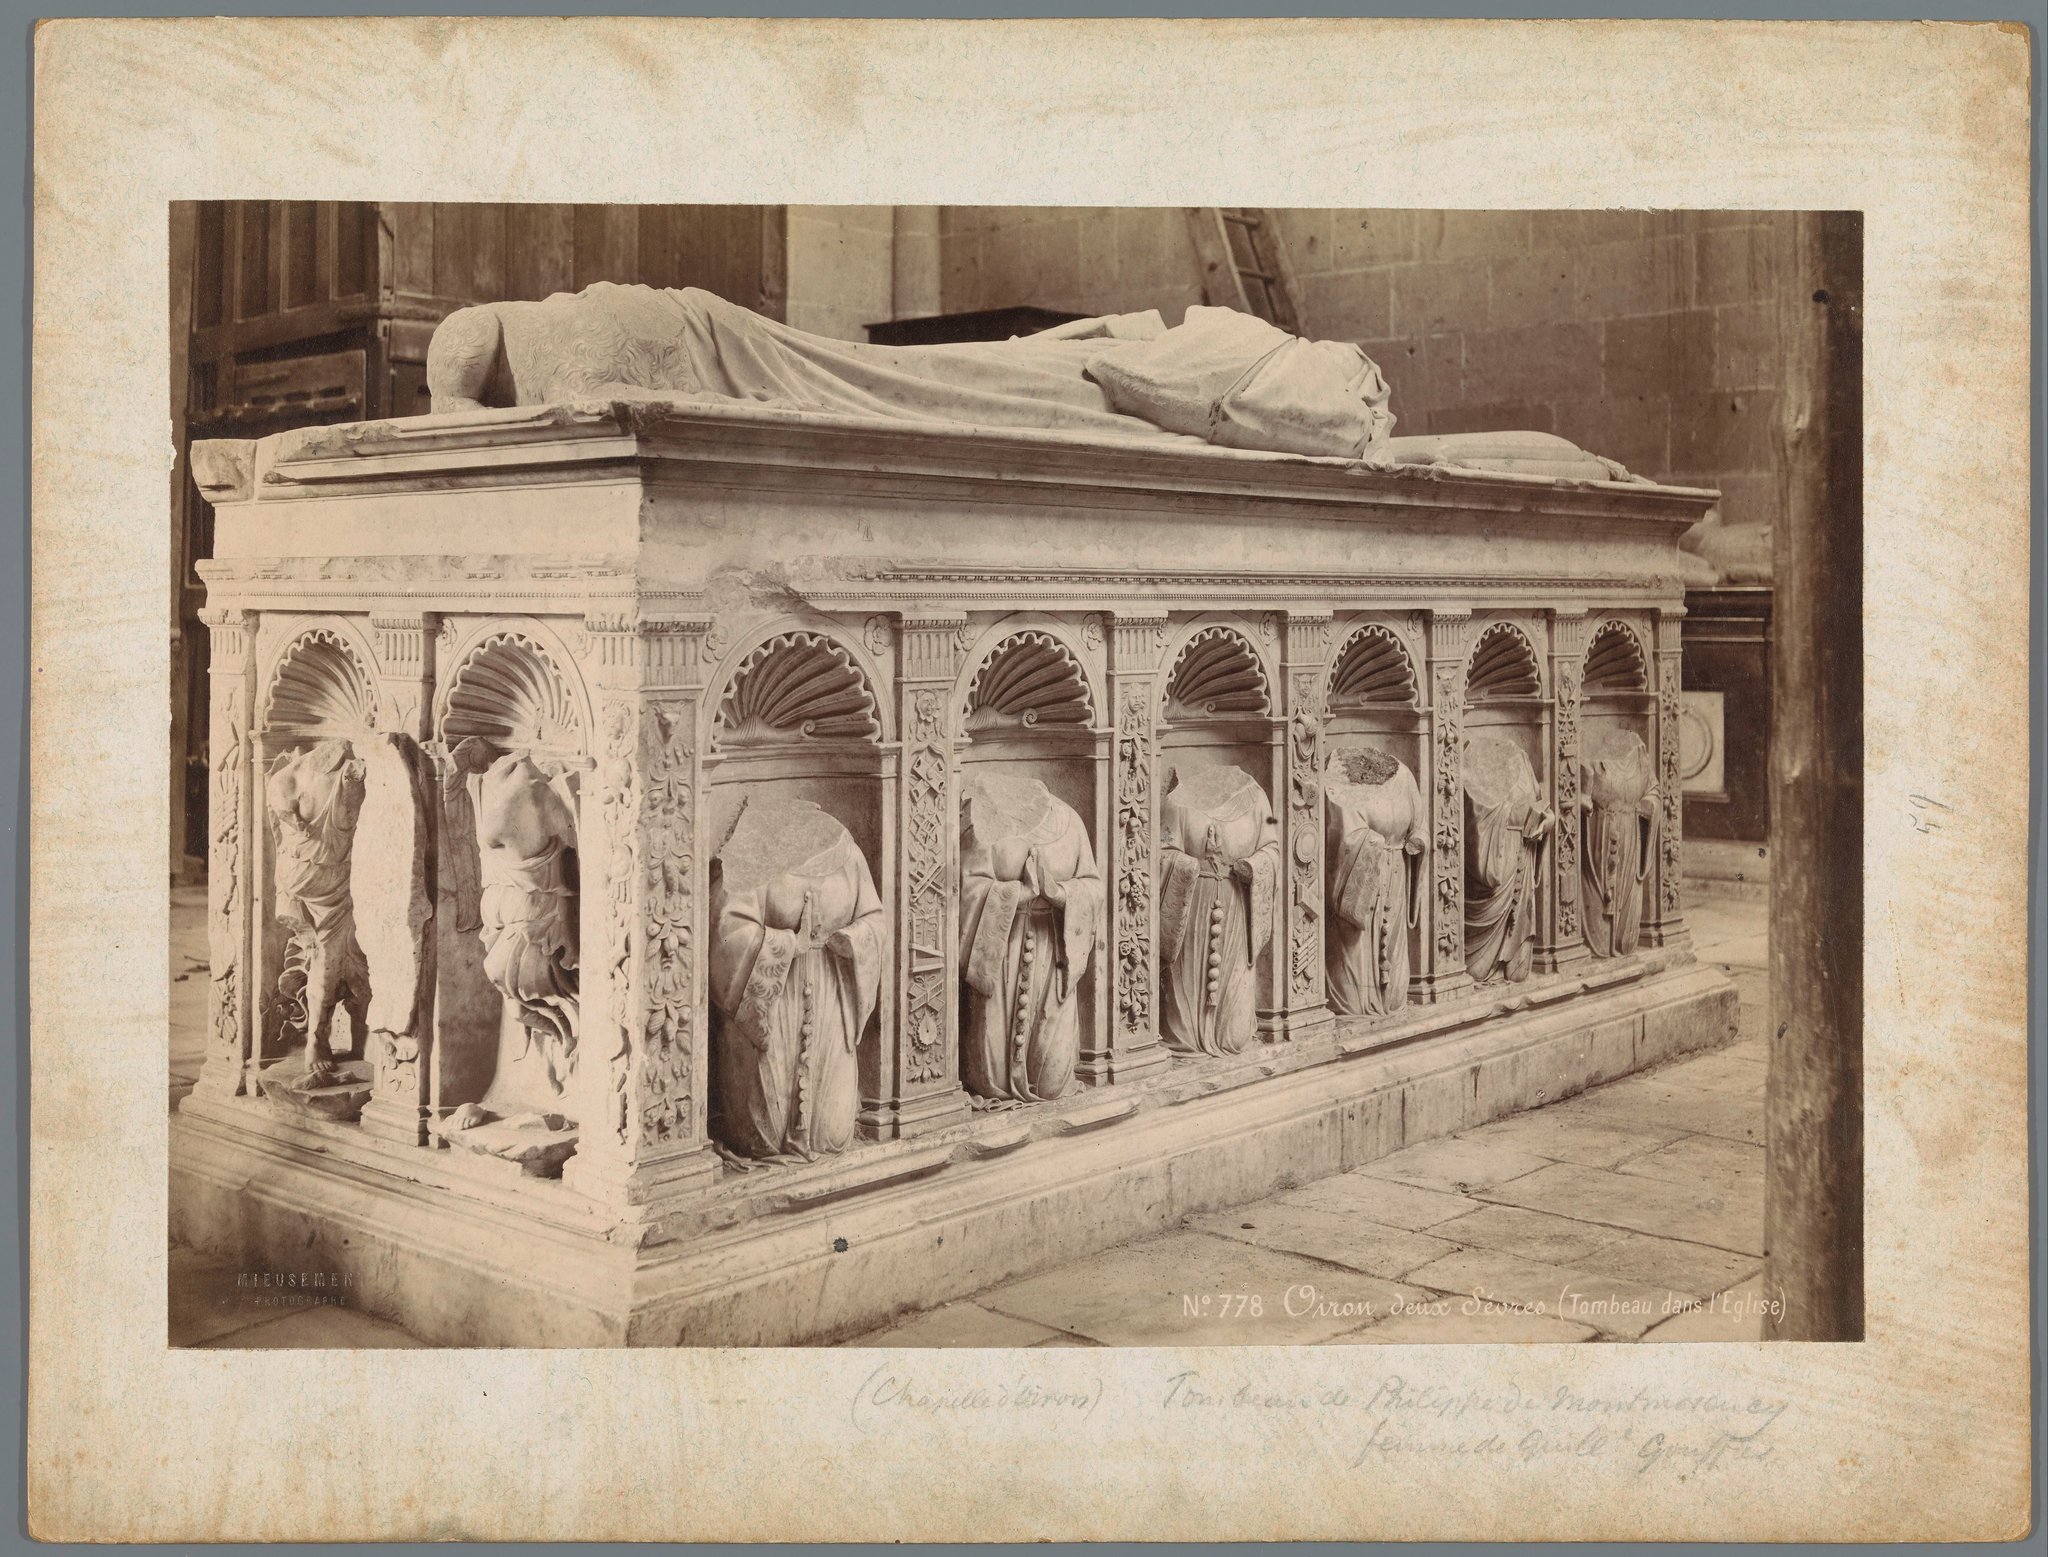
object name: photograph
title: Oiron deux Sèvres (Tombeau dans l'Eglise)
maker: séraphin-médéric mieusement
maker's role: fotograaf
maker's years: 1840-1905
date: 1875-1900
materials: cardboard, photographic support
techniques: albumen print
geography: oiron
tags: effigy, 'gisant' (portrait-figure on closed coffin or in 'castrum doloris'), transi, grave, tomb, interior of church, sculpture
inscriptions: name: ‘MIEUSEMENT PHOTOGRAPHE’, collector's mark: Lugt 3937, inscription: ‘MONUMENTS HISTORIQUES’, inscription: ‘(Chapelle d'Oiron) Tombeau de Philippe de Montmorency femme de Guille Gouffies’, inscription: ‘pl XIII stijlkast’, number: ‘No. 778’